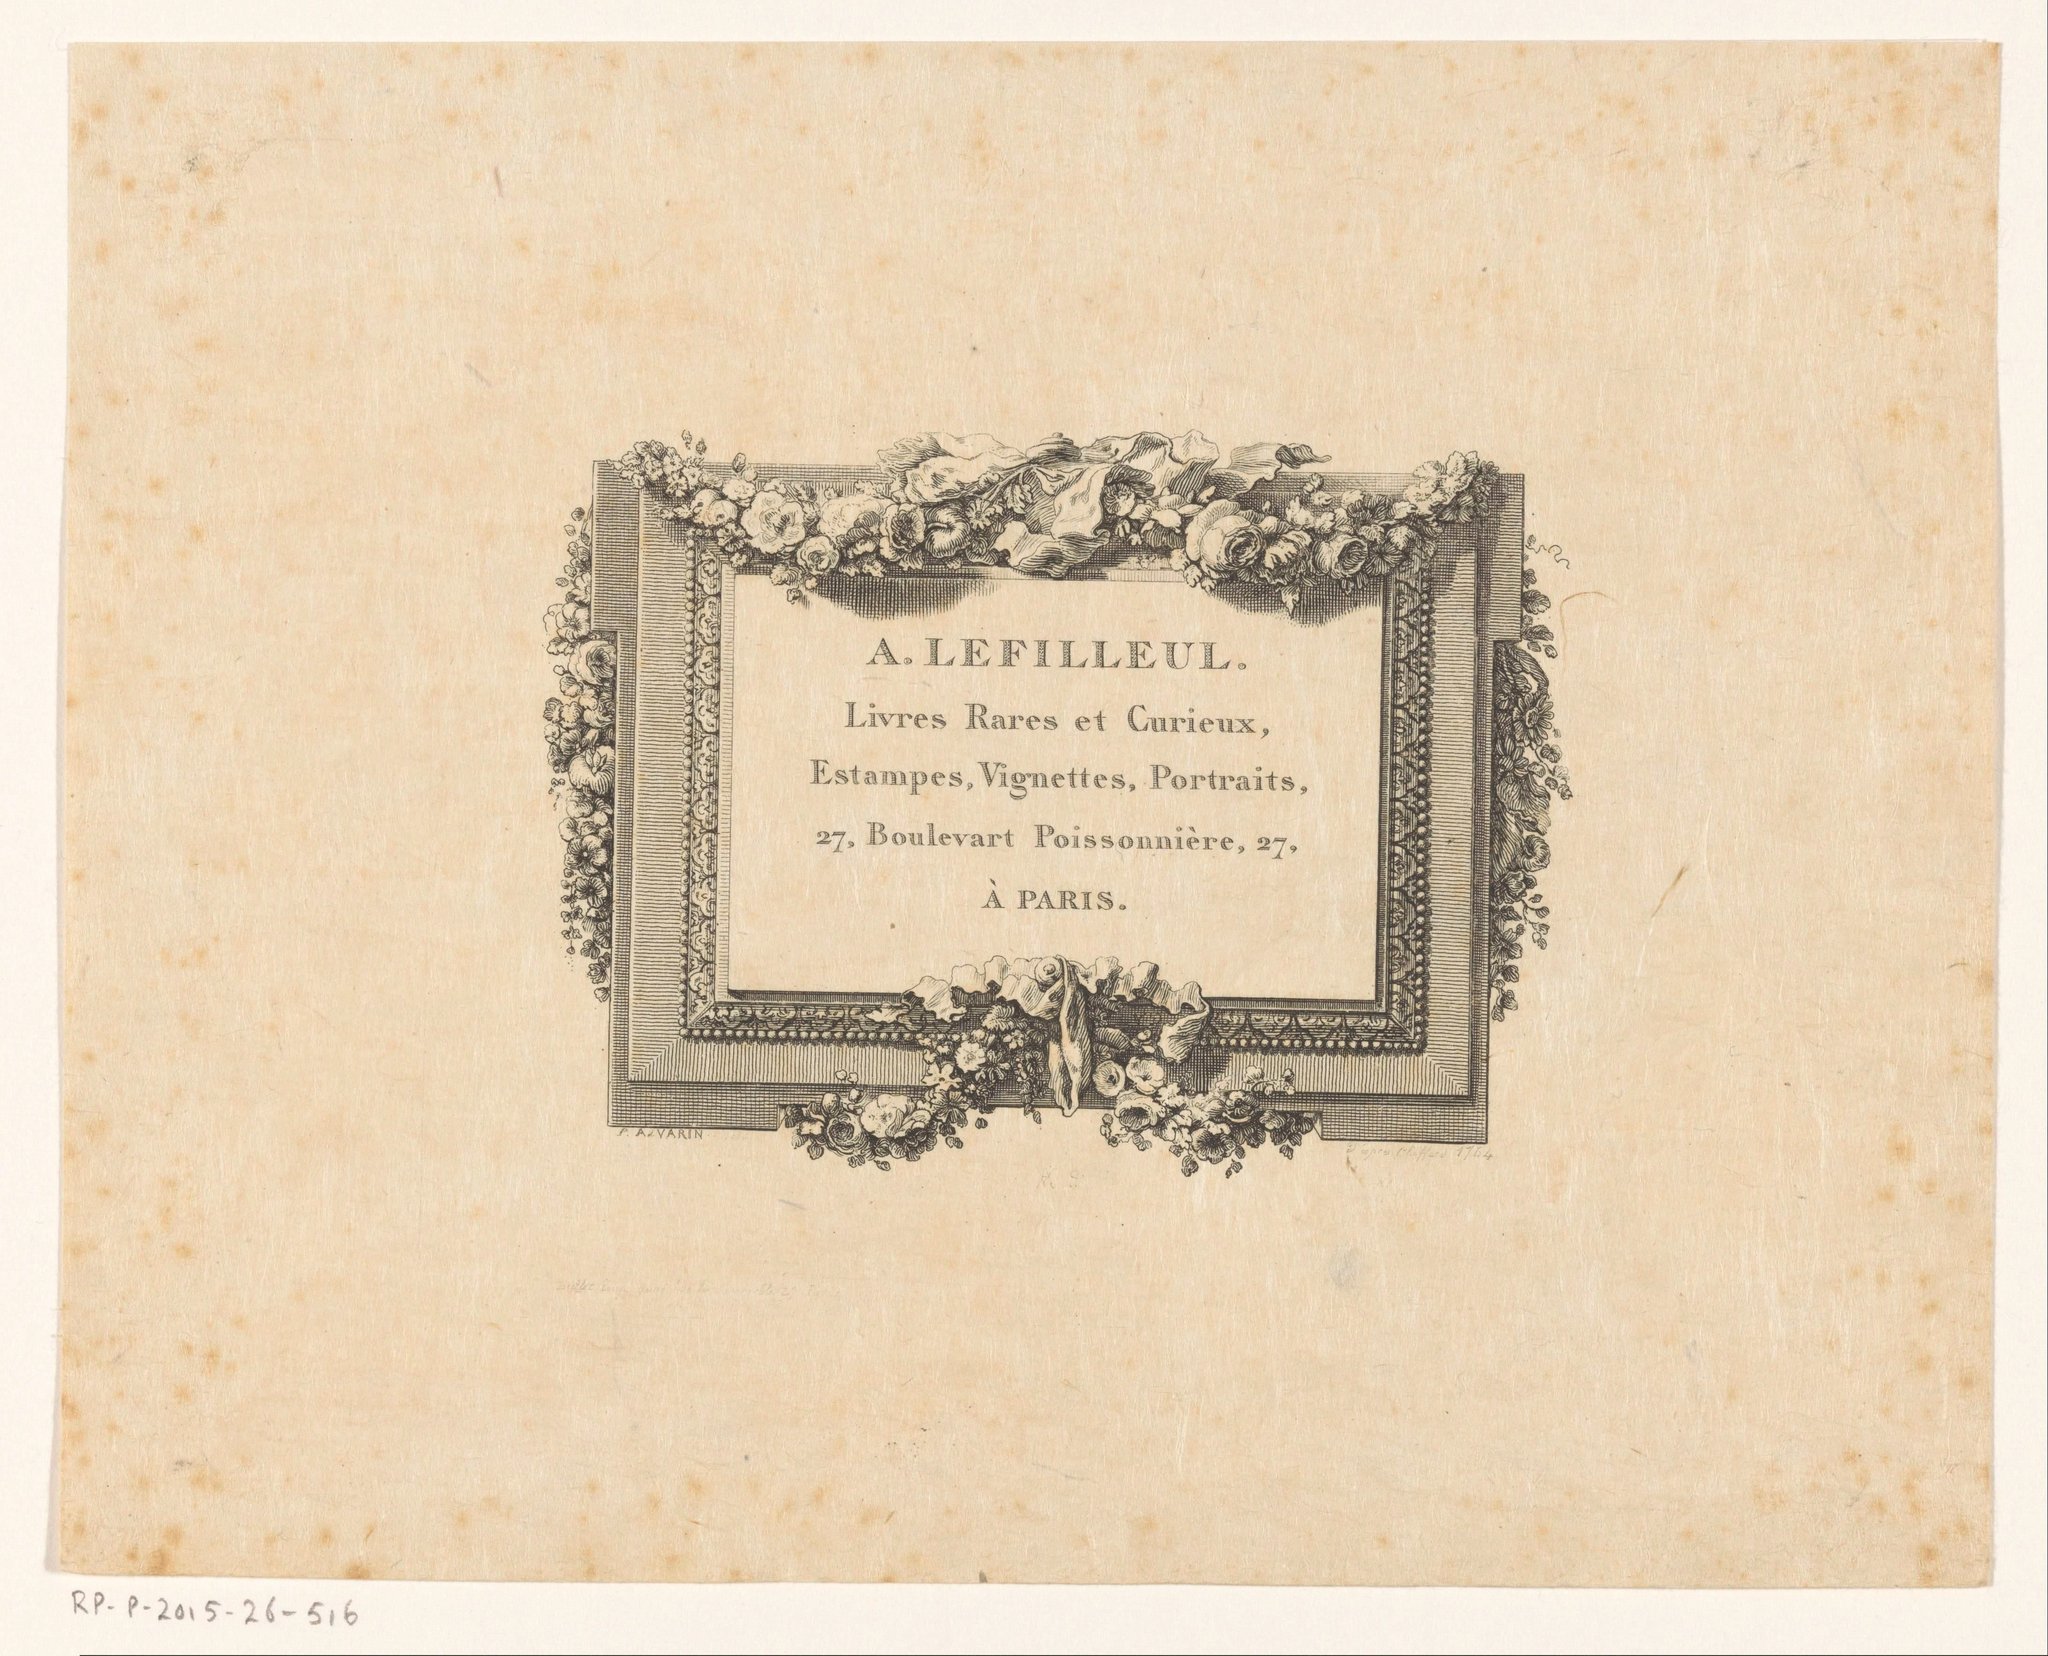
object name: print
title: Visitekaartje van boek- en prenthandel A. Lefilleul te Parijs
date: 1831-1897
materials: paper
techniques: engraving, etching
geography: paris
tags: flowers ~ ornament, book-shop, bookseller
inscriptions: collector's mark: Lugt 4780, collector's mark: Lugt 2228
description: Naar een visitekaartje vervaardigd door Choffard in 1764 voor juwelier Drais te Parijs.